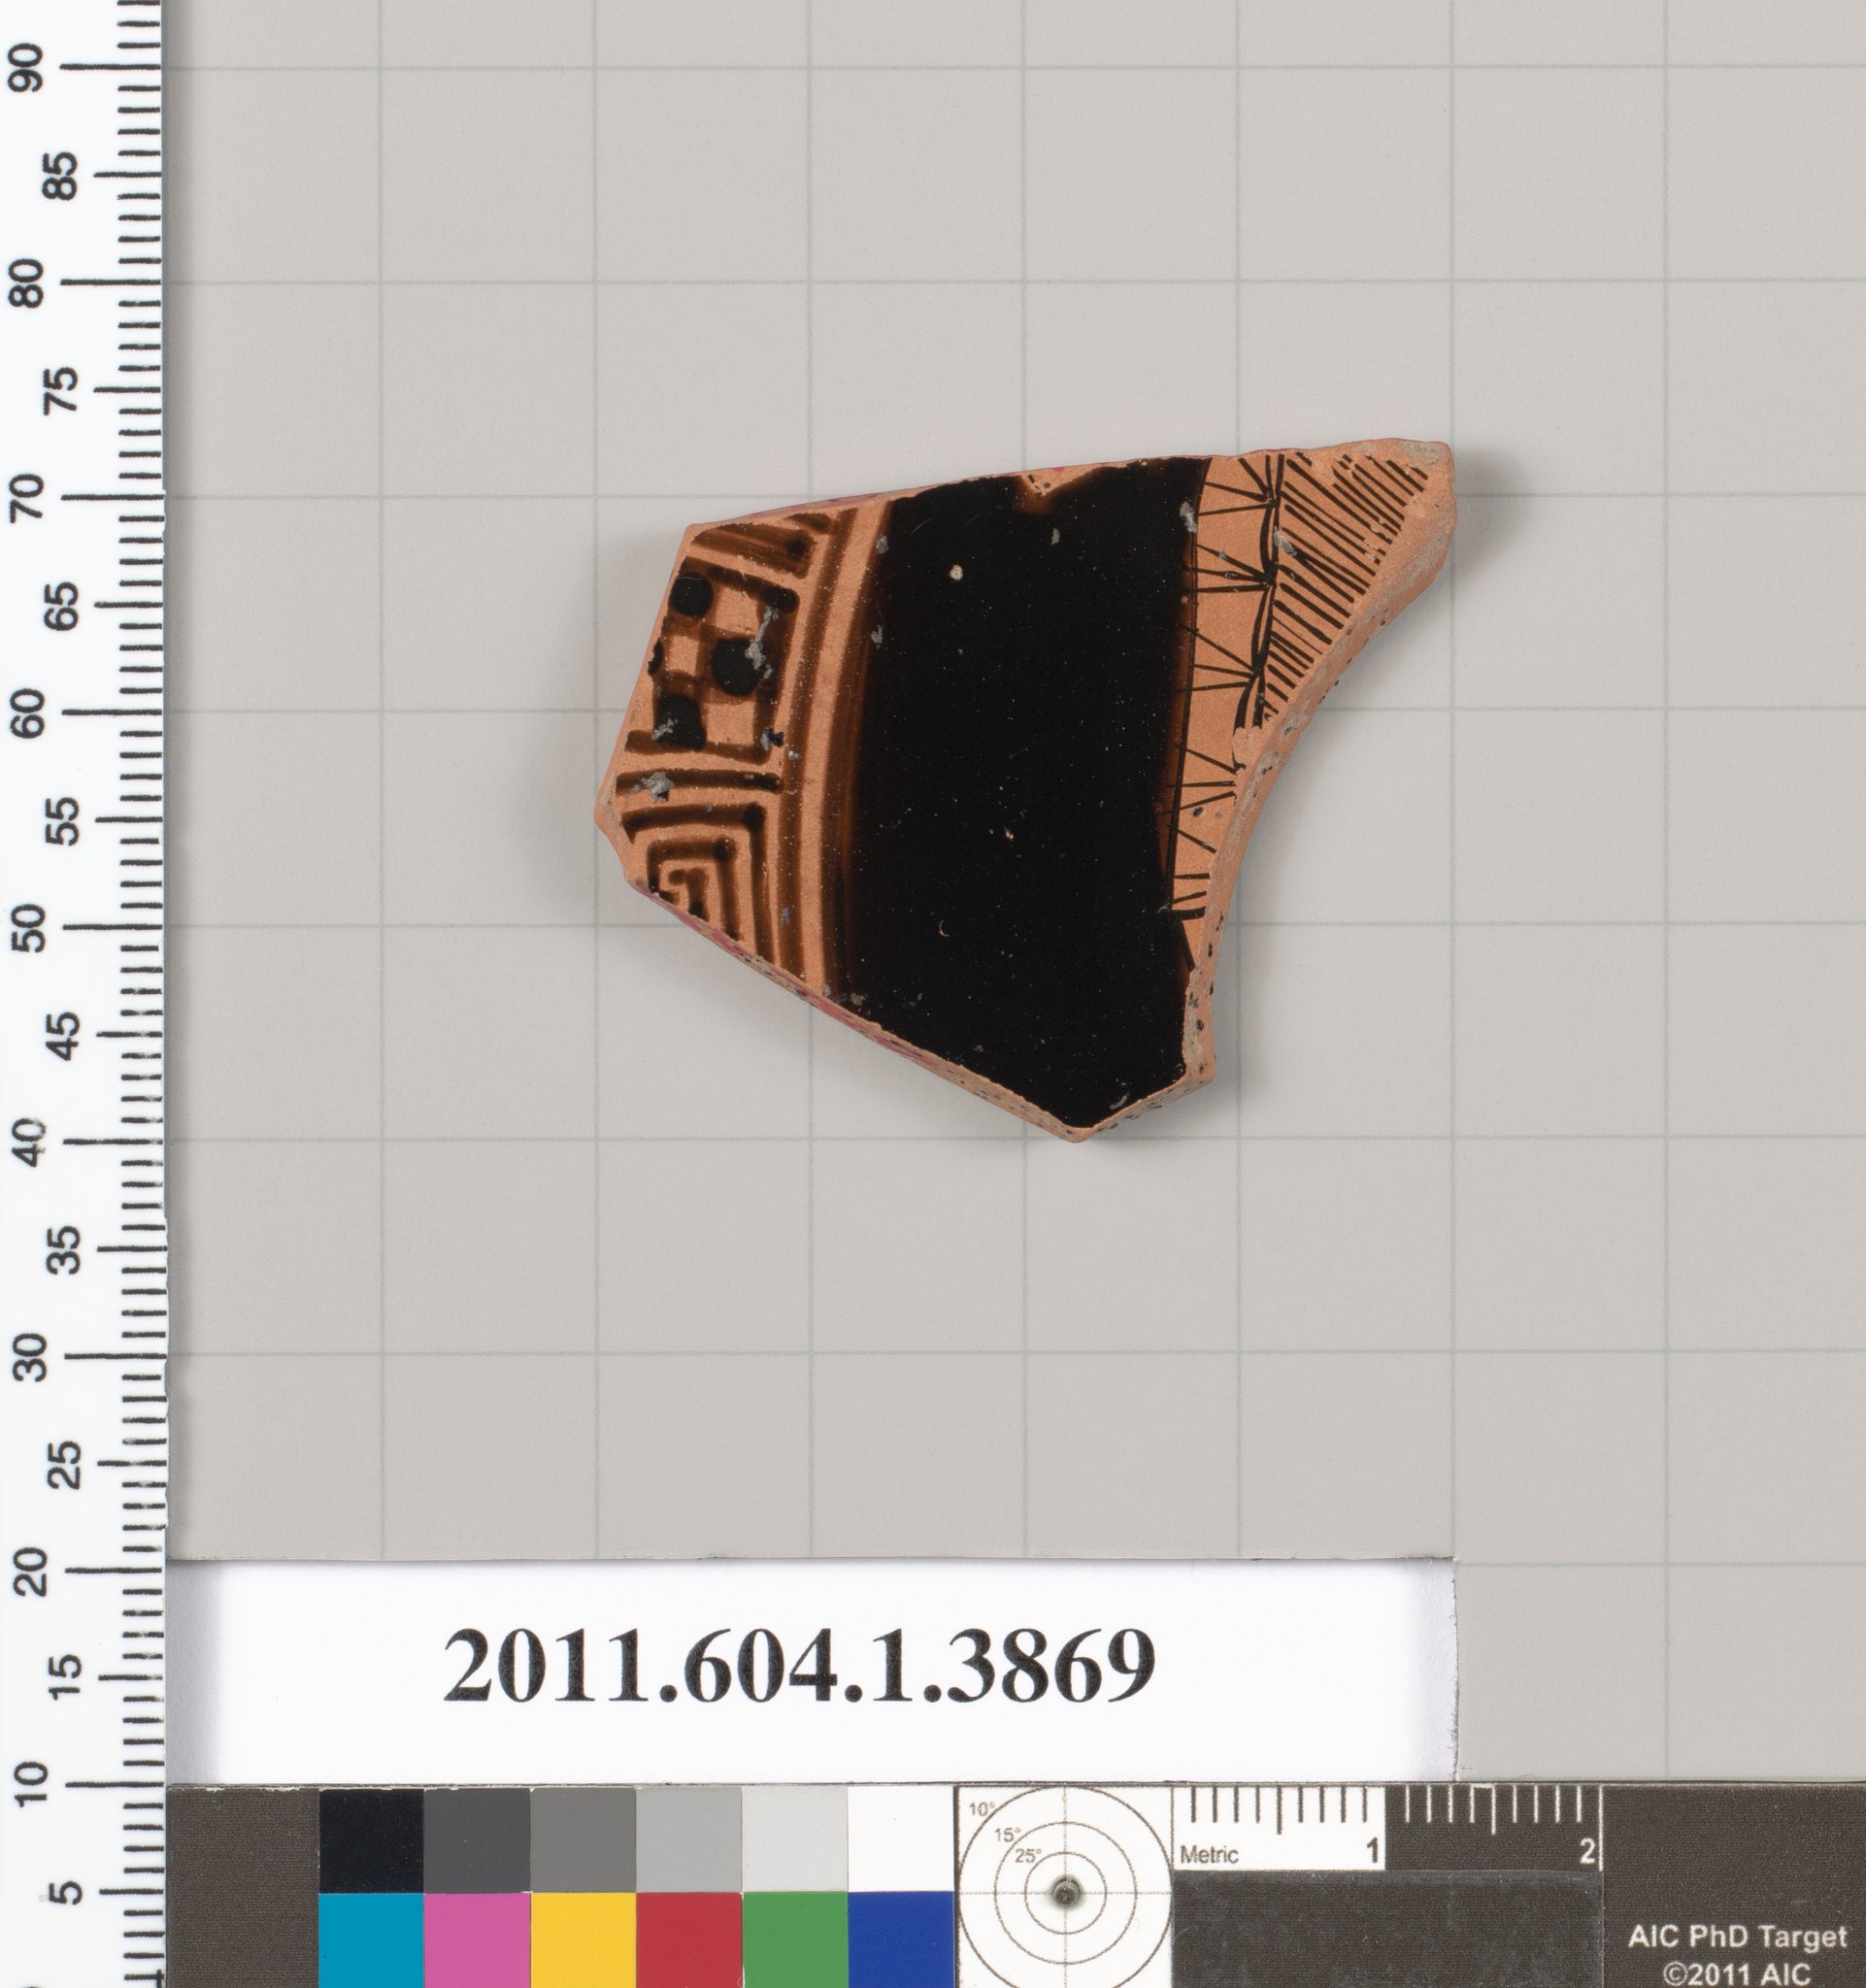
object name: kylix fragment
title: Terracotta fragment of a kylix (drinking cup)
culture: greek, attic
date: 475-451 BCE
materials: terracotta